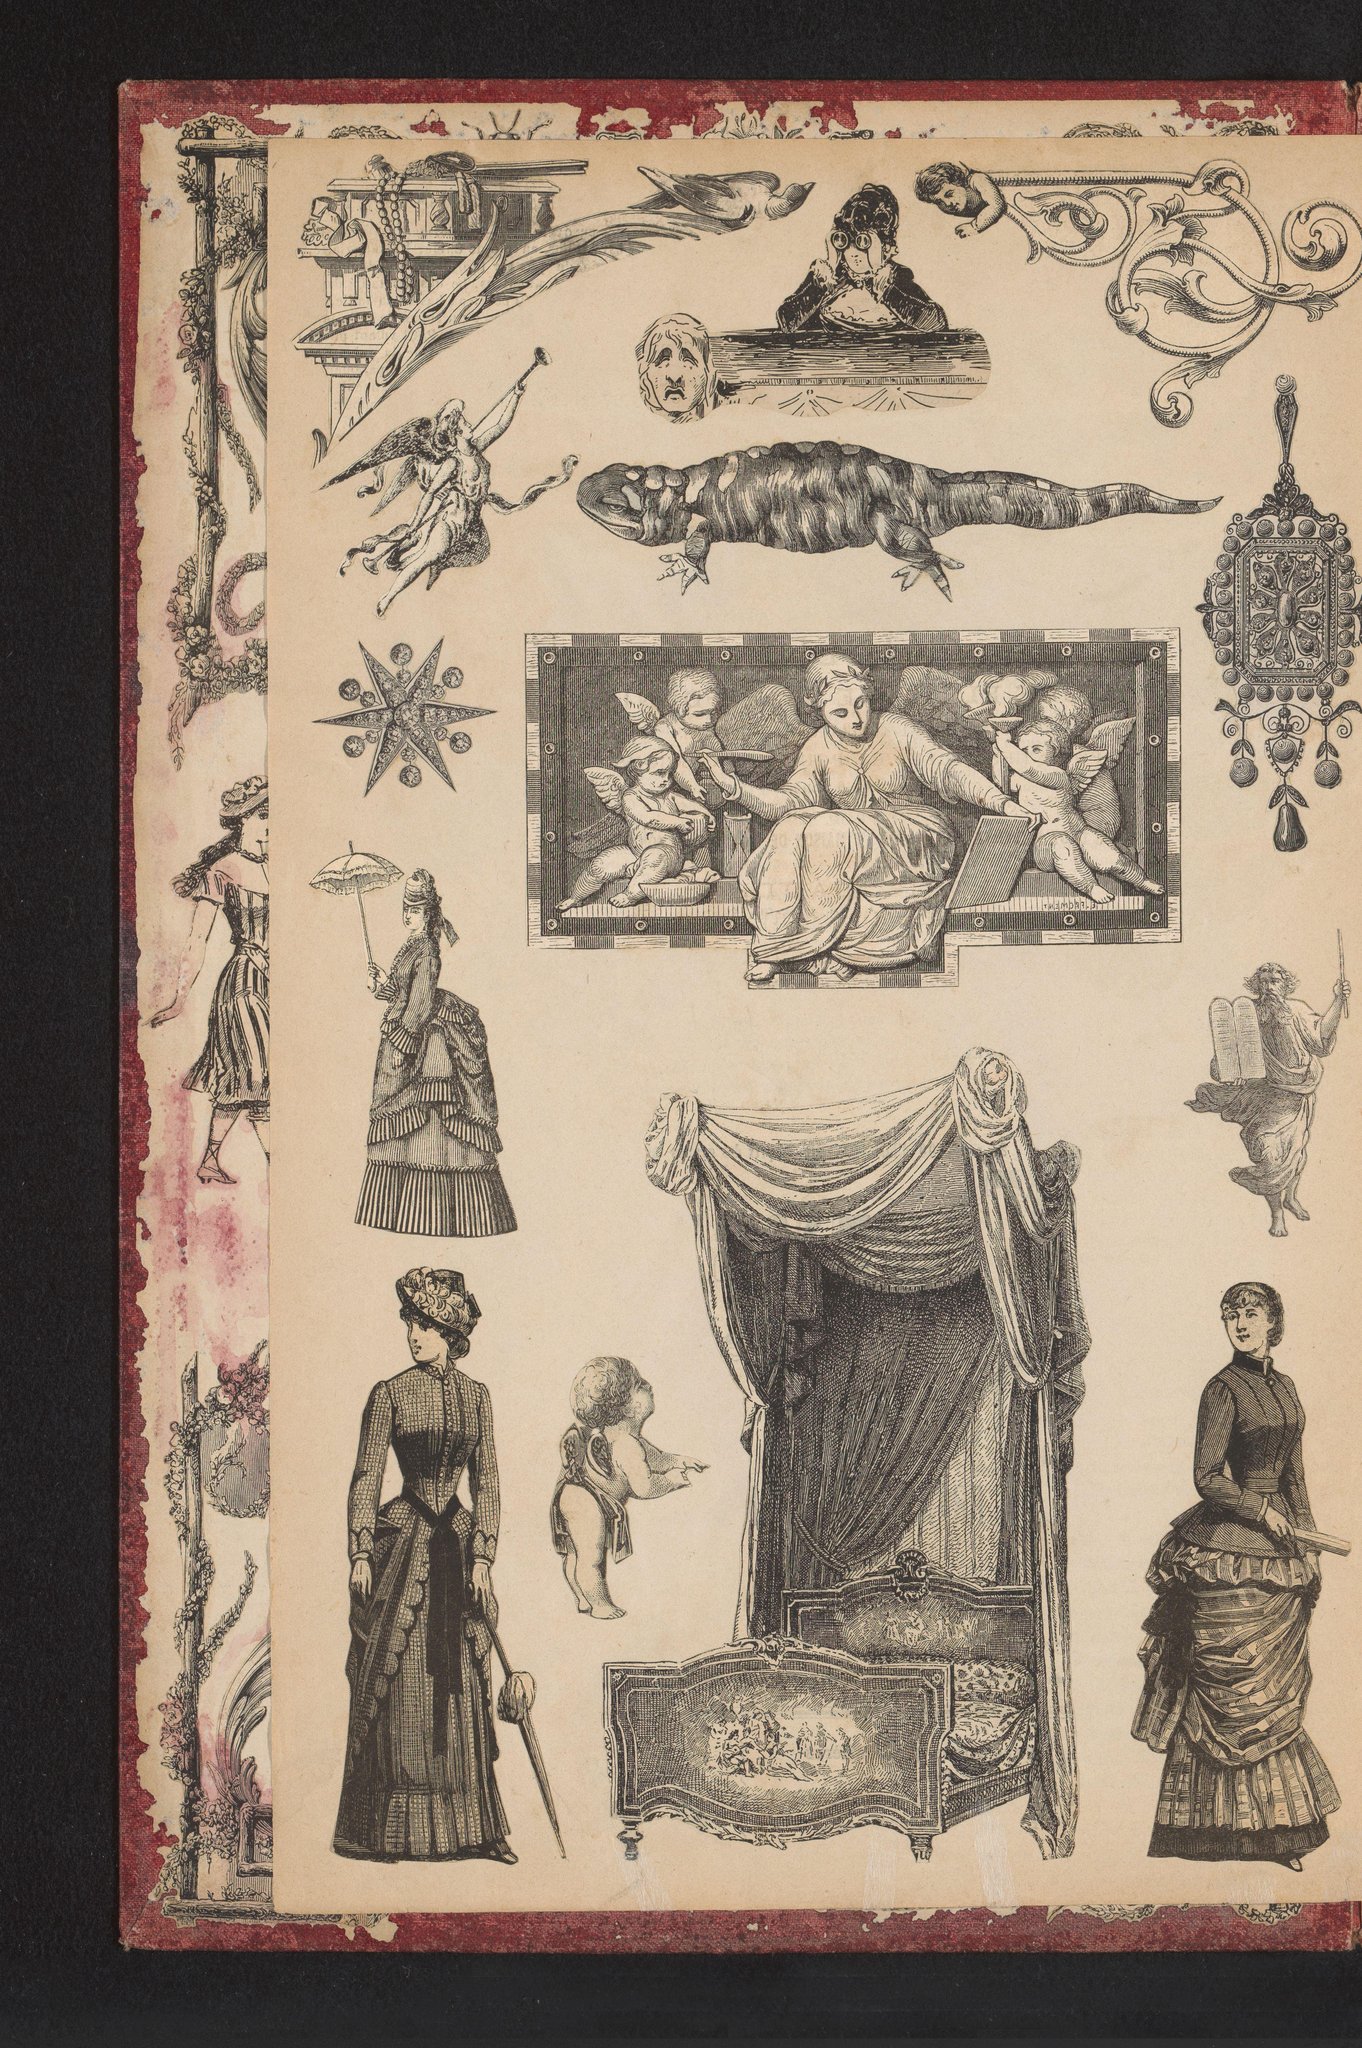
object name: collage visual work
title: Collage van uitgeknipte prenten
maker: Anonymous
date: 1870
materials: paper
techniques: engraving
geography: paris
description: Collage van uitgeknipte prenten. Onderdeel van een album met 32 bladen, aan beide zijden beplakt met uitgeknipte prenten, vermoedelijk afkomstig uit 19e-eeuwse tijdschiften.